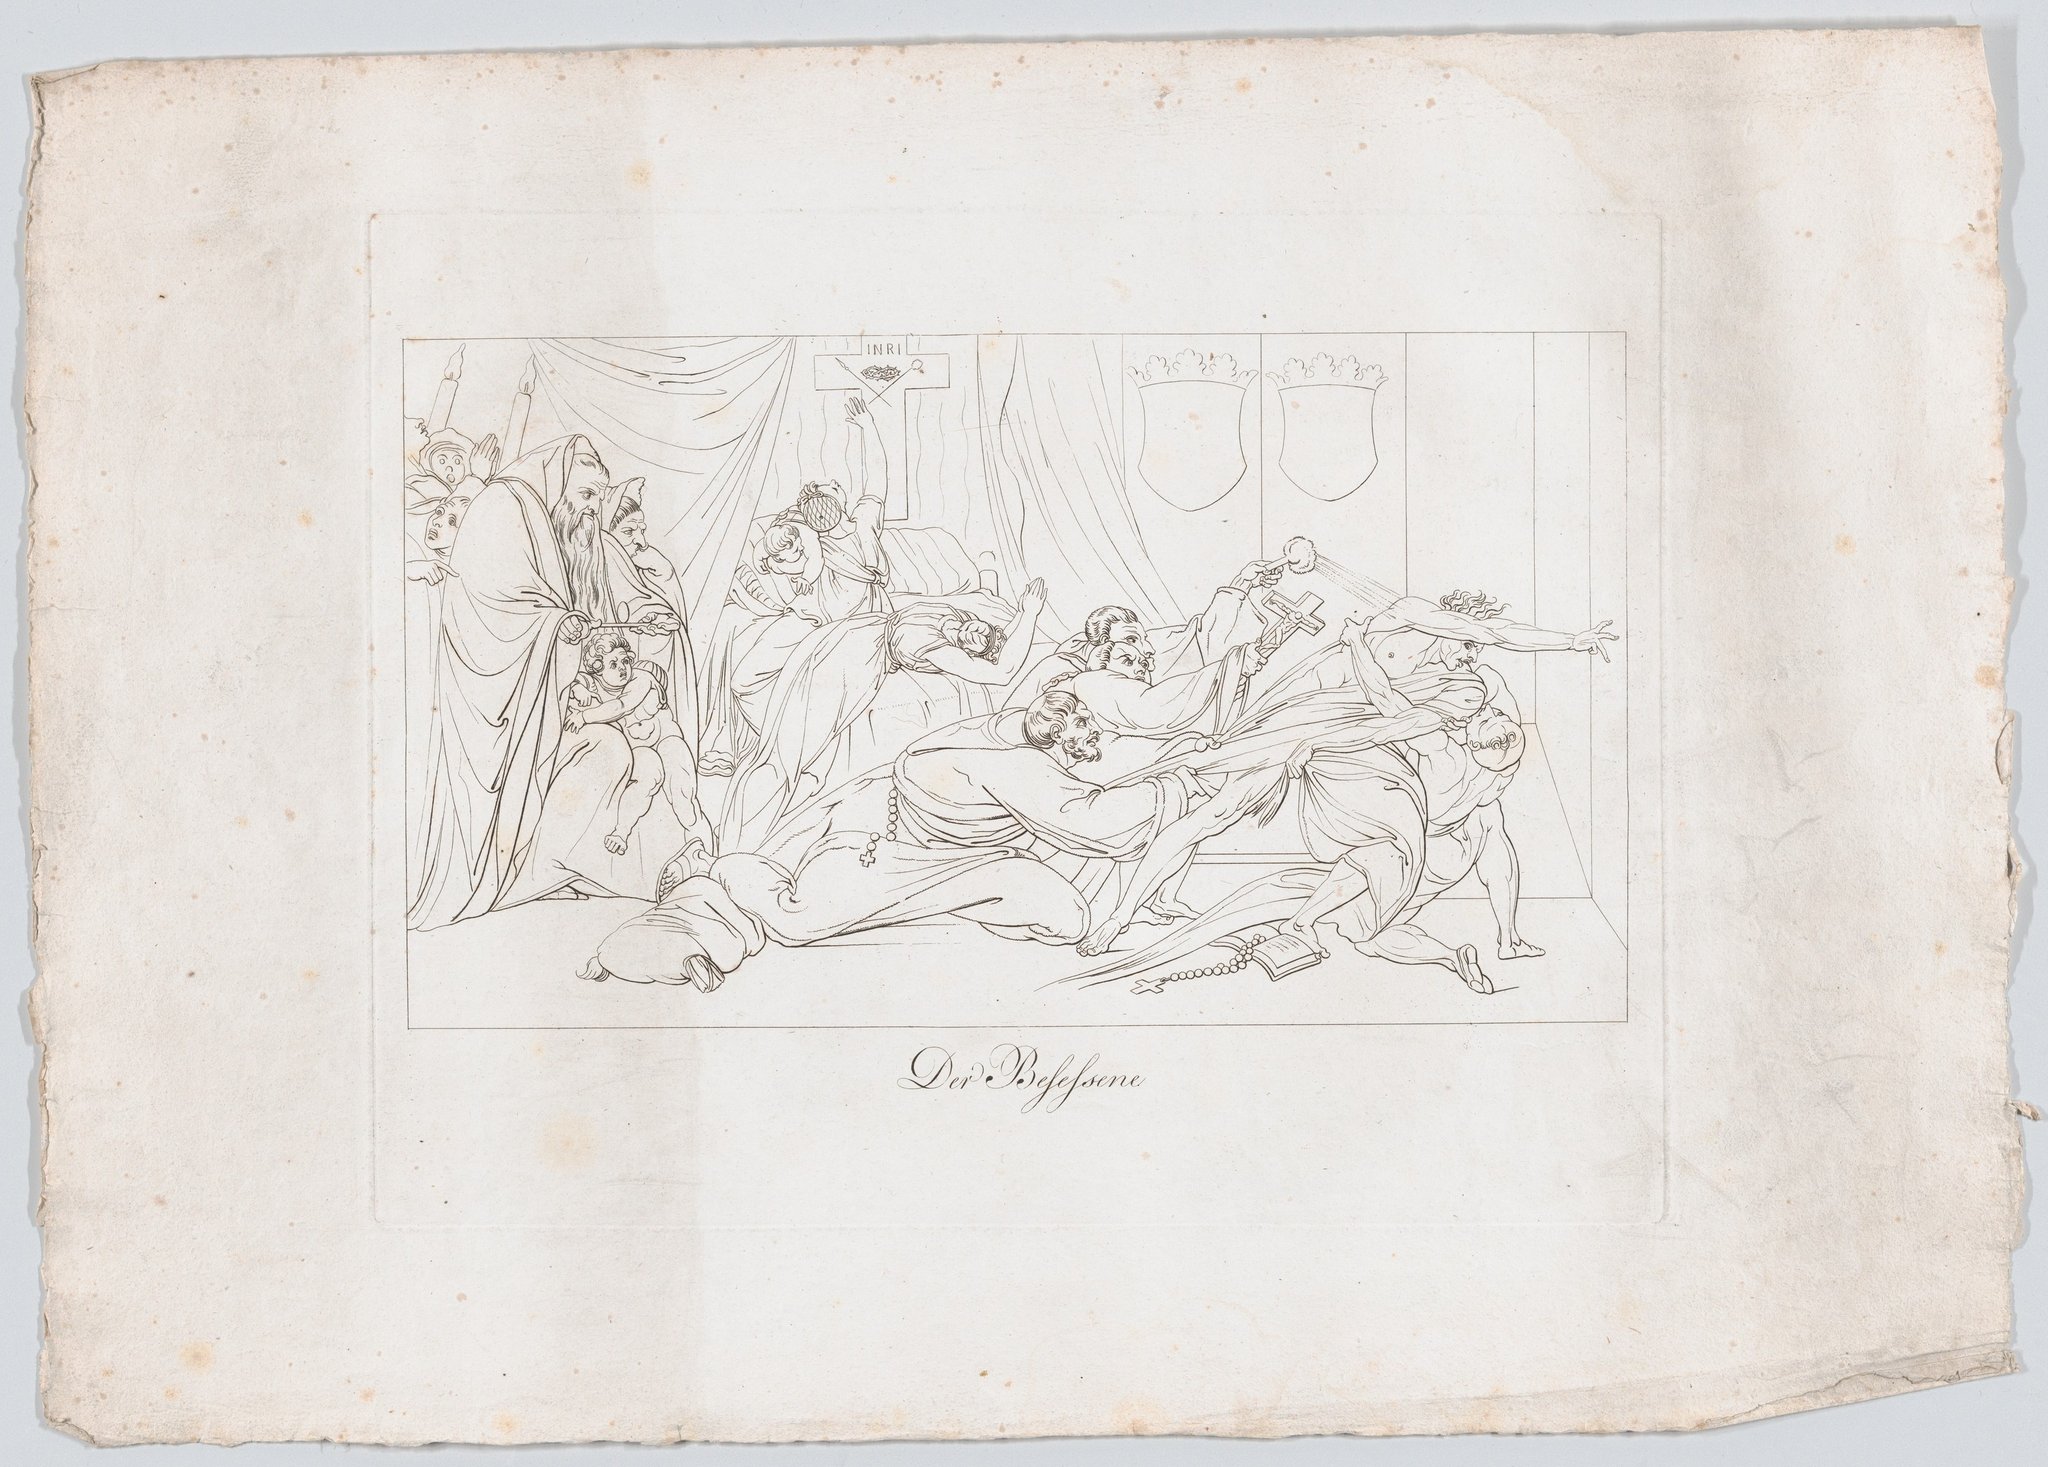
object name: print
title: Der Besessene (The Escapee: A Real Scene in the Hospital of San Spirito at Rome)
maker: john barlow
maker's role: engraver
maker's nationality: british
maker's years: 1759-1815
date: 1806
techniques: engraving, etching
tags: men,cross